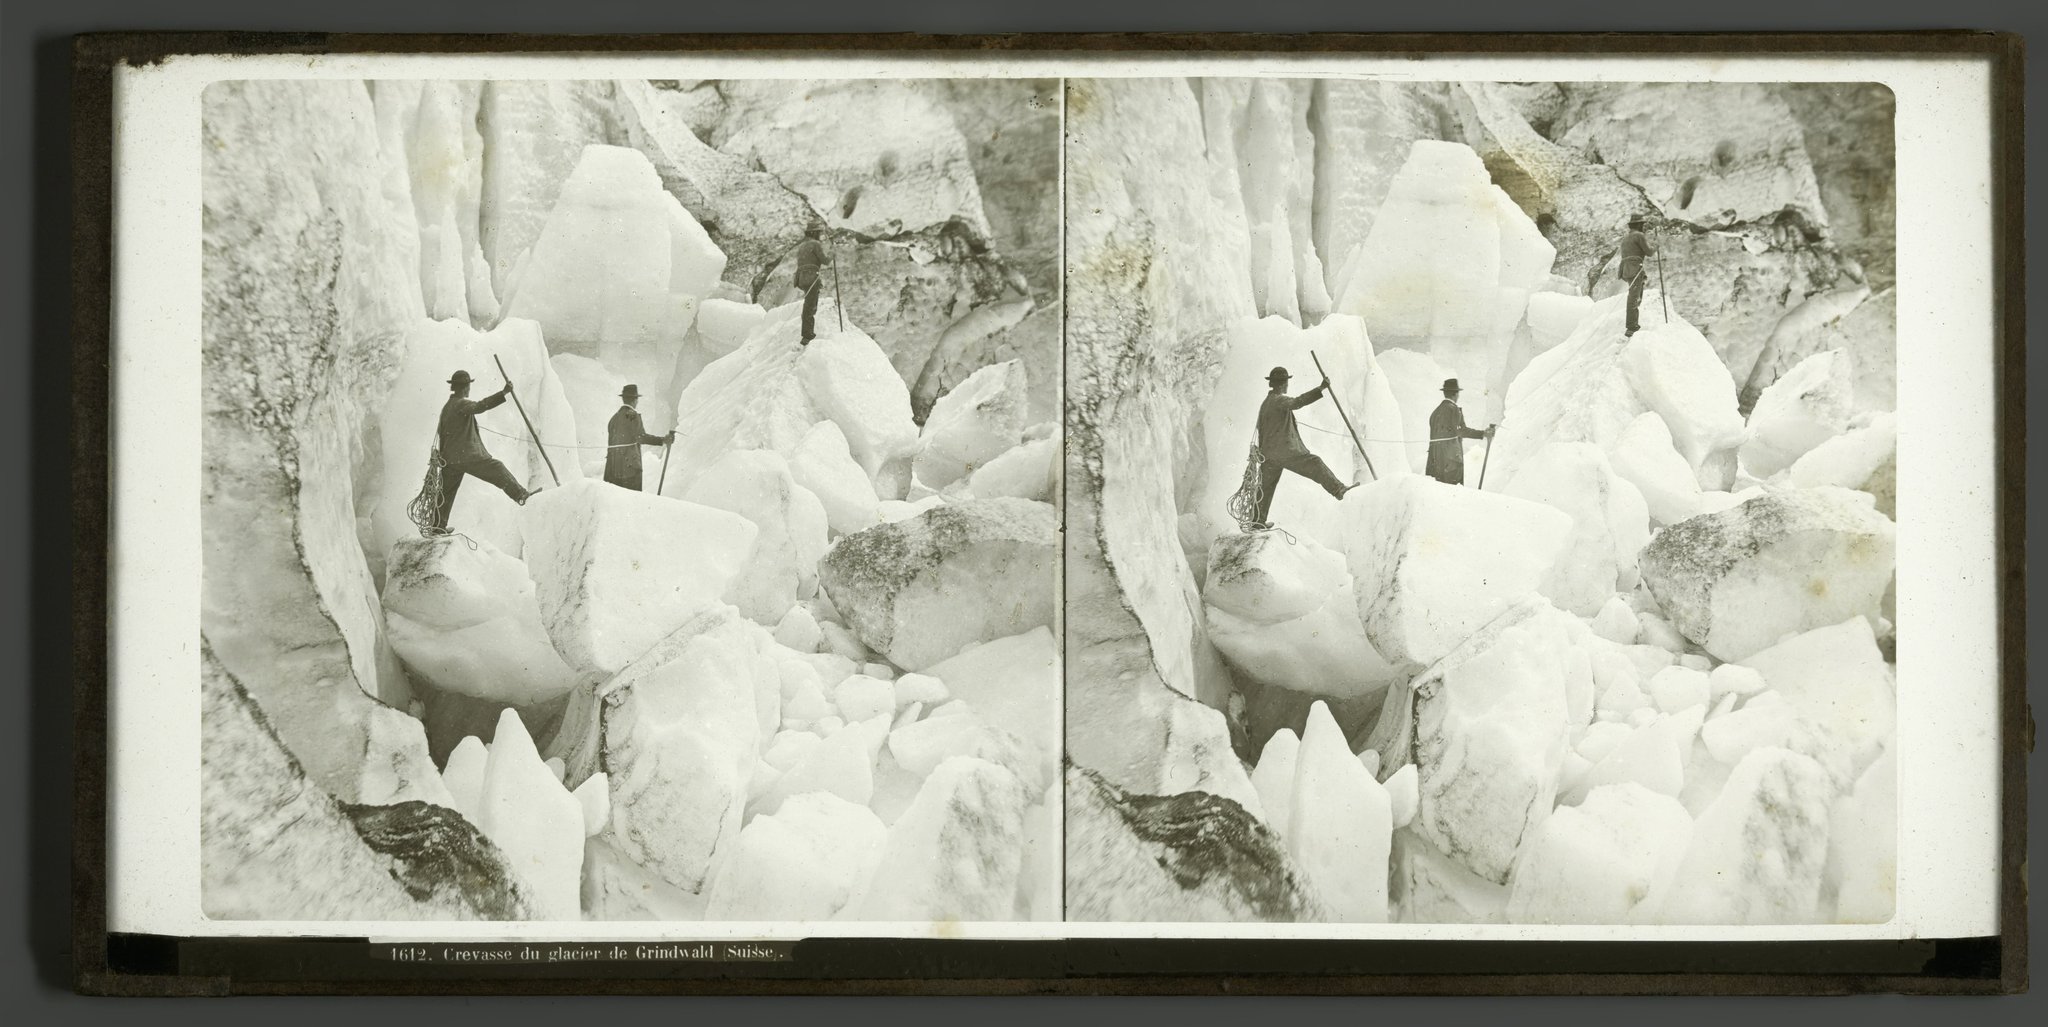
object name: stereoscopic photograph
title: Drie mannen beklimmen de Lage Grindelwaldgletsjer in Grindelwald, Zwitserland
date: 1860-1870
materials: glass, paper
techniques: slide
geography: grindelwald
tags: glacier (+ landscape with figures, staffage)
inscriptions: inscription: ‘1612’